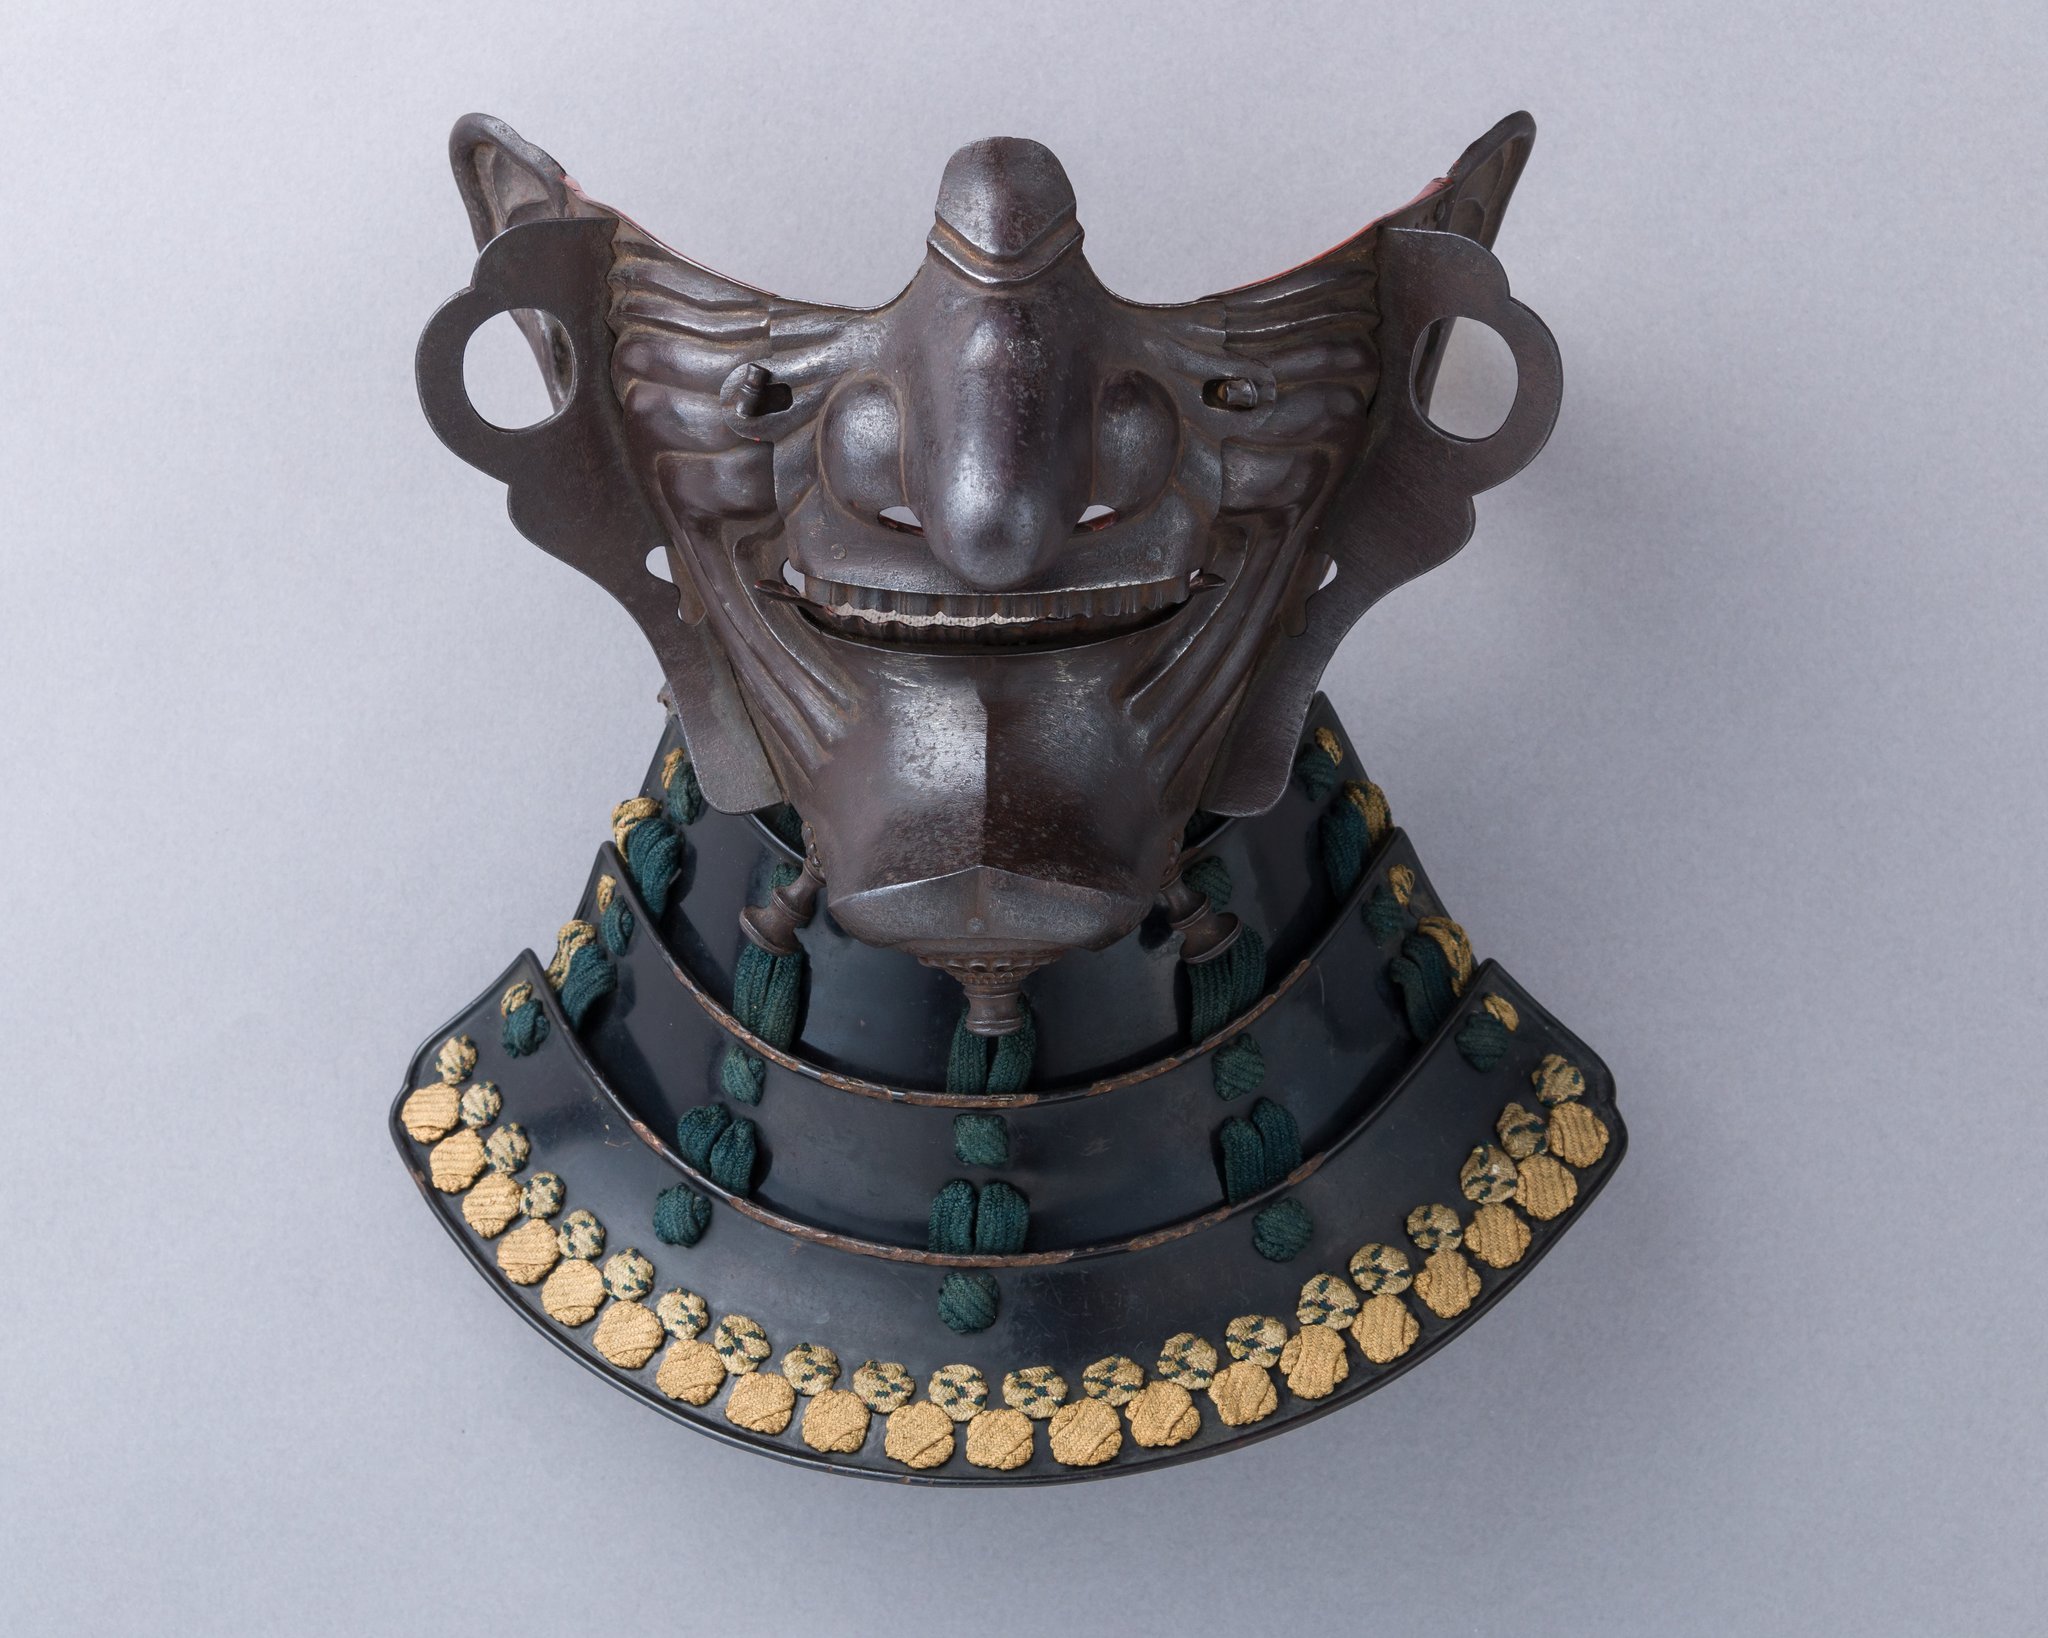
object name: half mask ho ate with neck guard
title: Half Mask (Ho-ate) with Neck Guard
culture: japanese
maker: myōchin munetomo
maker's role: armorer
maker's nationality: japanese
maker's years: 1700-1750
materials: iron, lacquer, textile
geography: japan